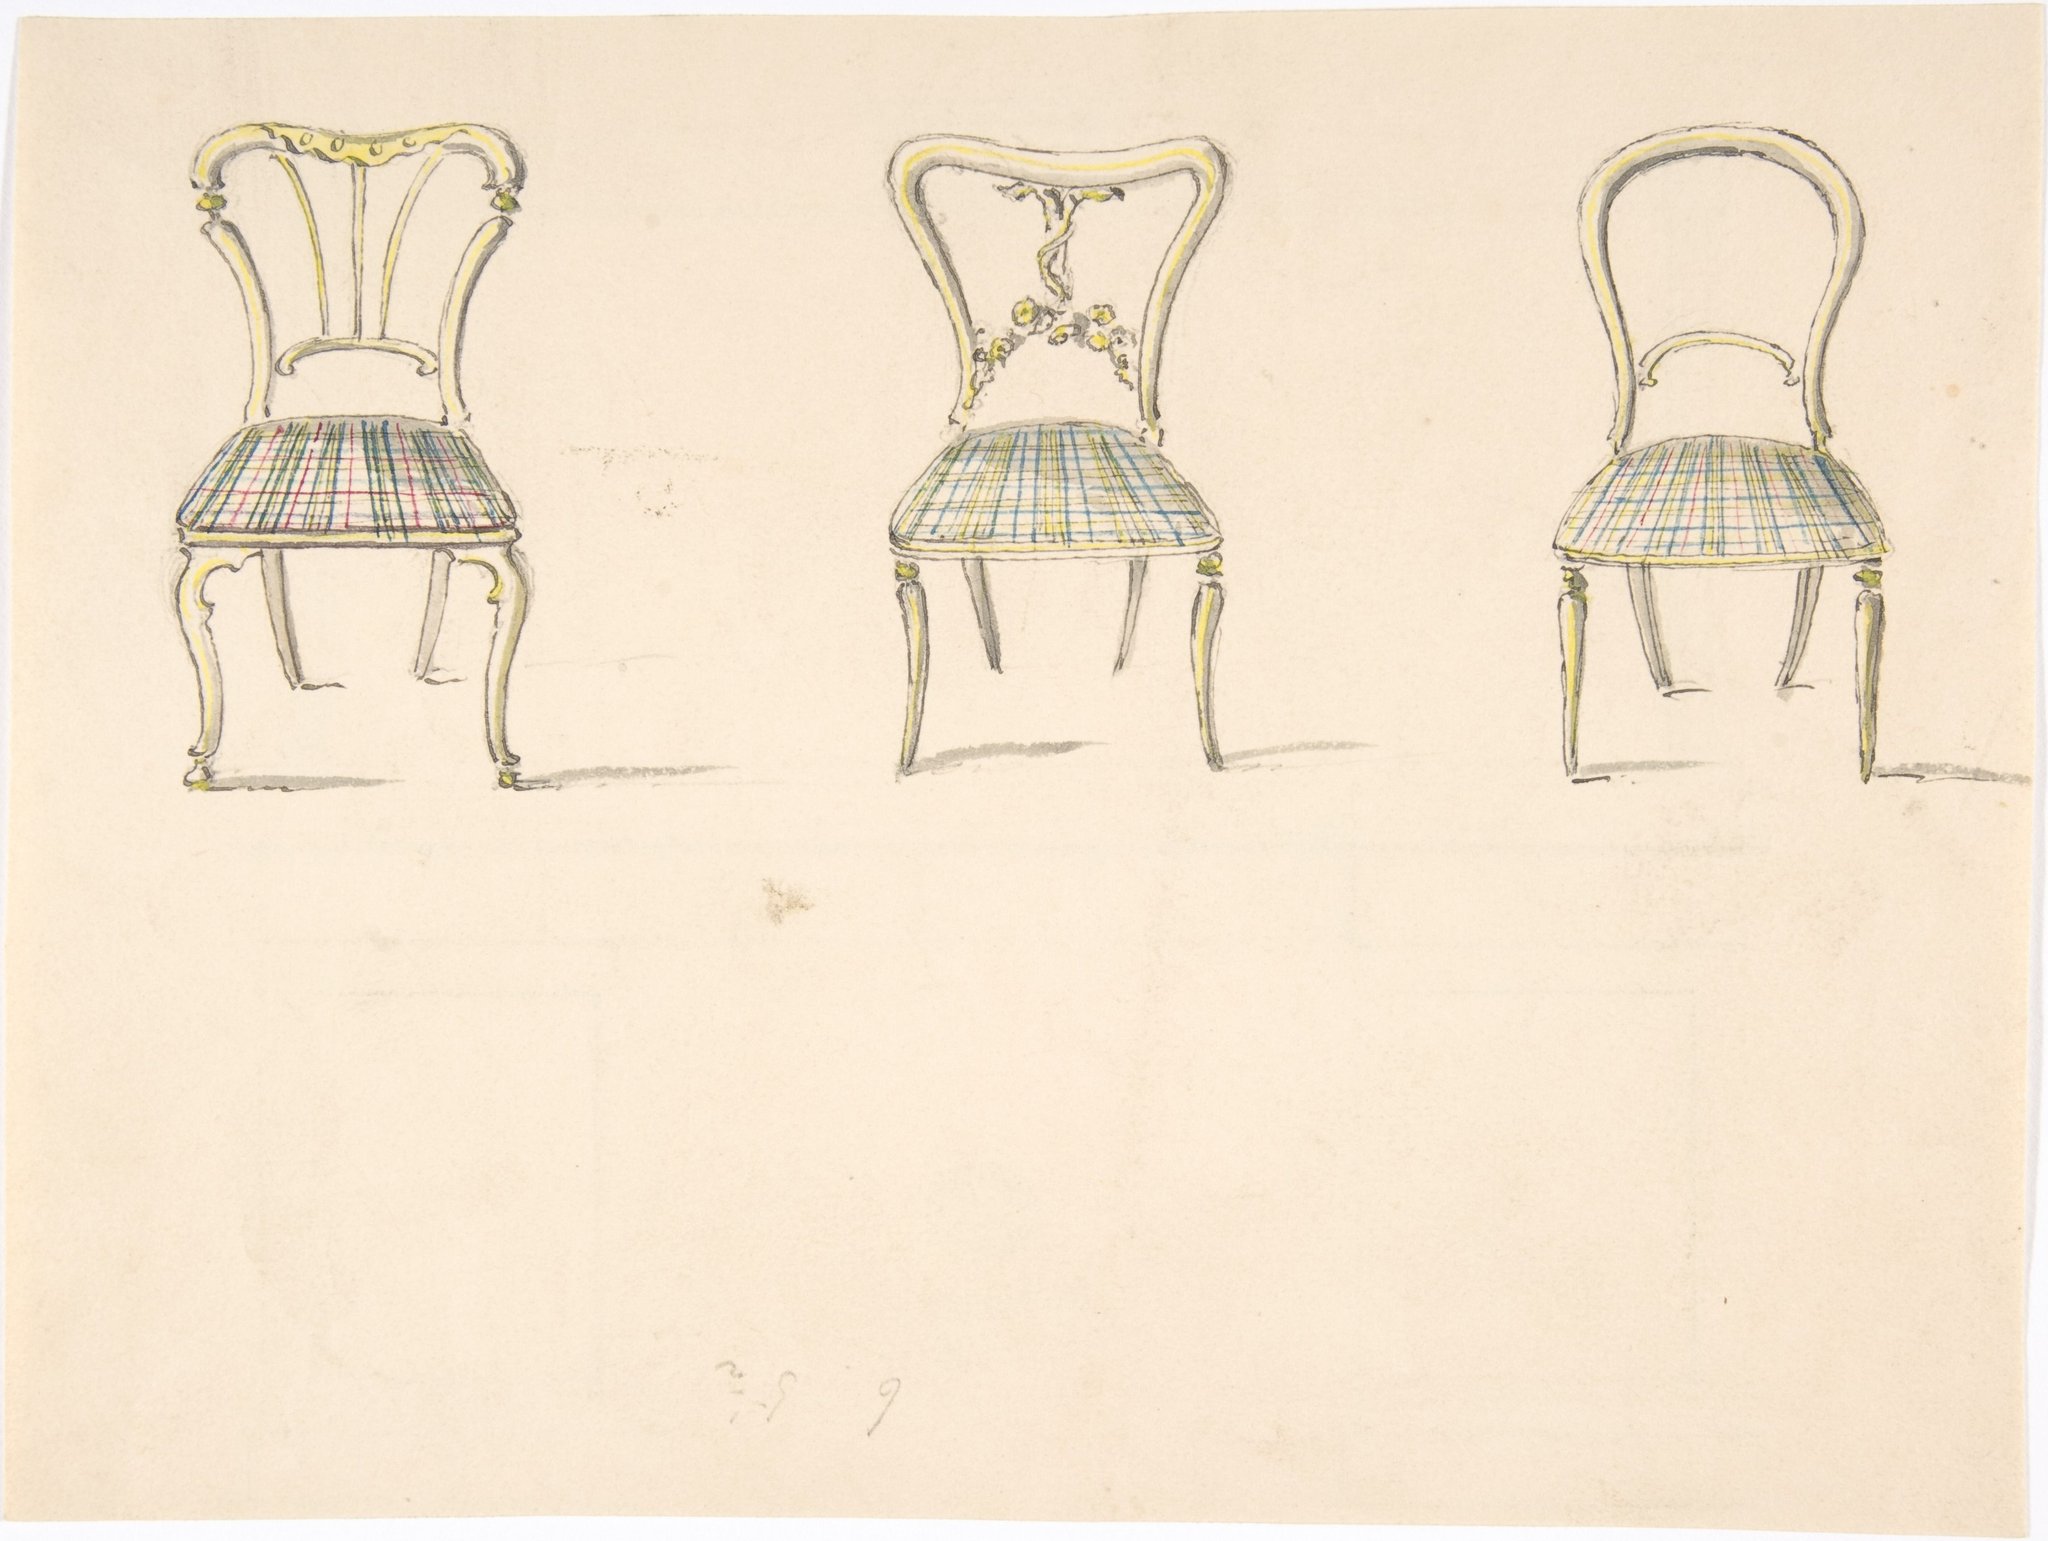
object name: drawing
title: Design for Three Chairs with Curved Backs (verso: Sketch for a Sideboard)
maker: anonymous, british, 19th century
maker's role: artist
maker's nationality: british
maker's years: 1800-1900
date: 1801-1833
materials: graphite, ink, watercolor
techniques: pen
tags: chairs